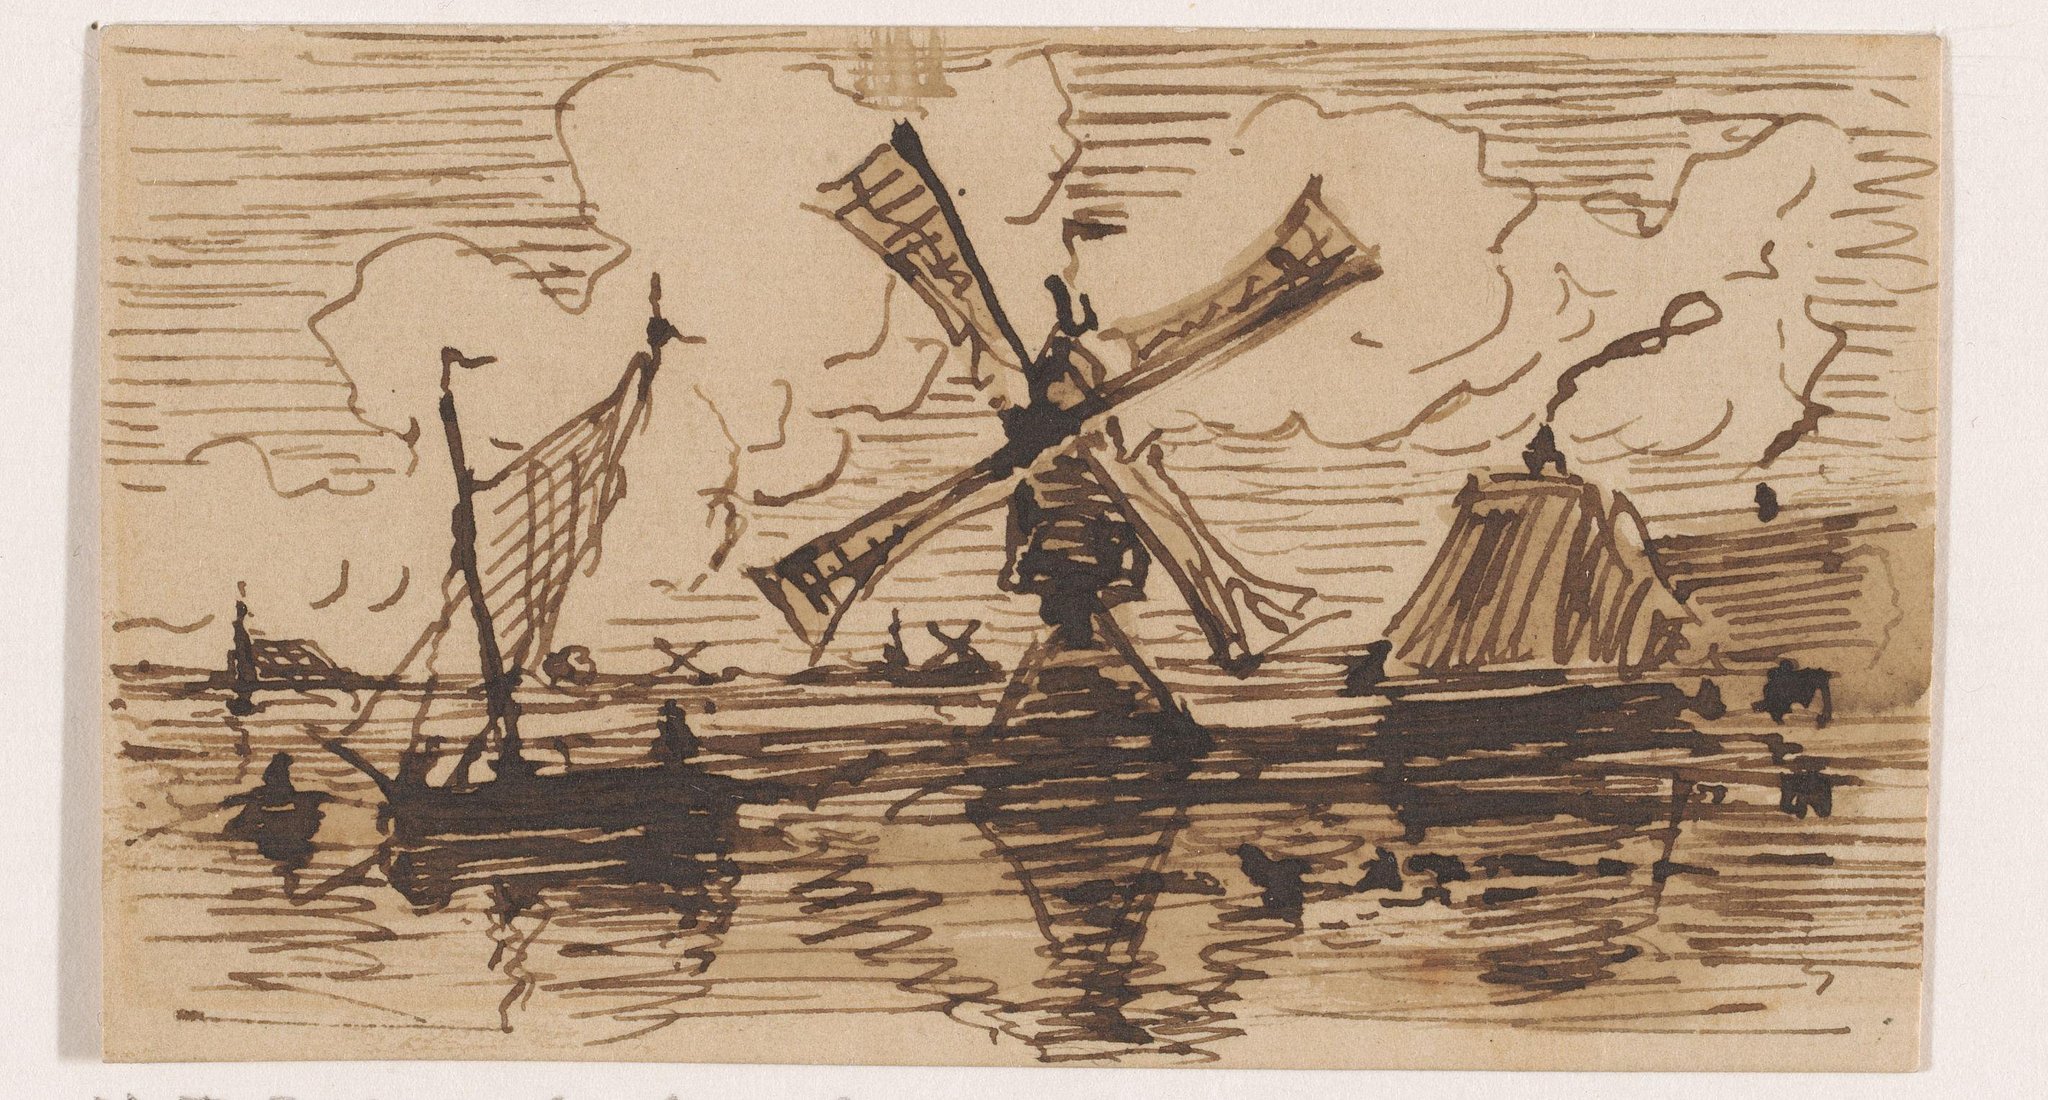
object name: visiting card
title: Rivierlandschap met molen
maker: johannes tavenraat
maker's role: draughtsman, painter, print maker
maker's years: 1809-1881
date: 1869-1870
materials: cardboard, ink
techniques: pen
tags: windmill in landscape, river (+ landscape with figures, staffage)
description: Rivierlandschap met molen. Getekend op de keerzijde het visitekaartje van: 'De Heer en Mevrouw Tiele'.